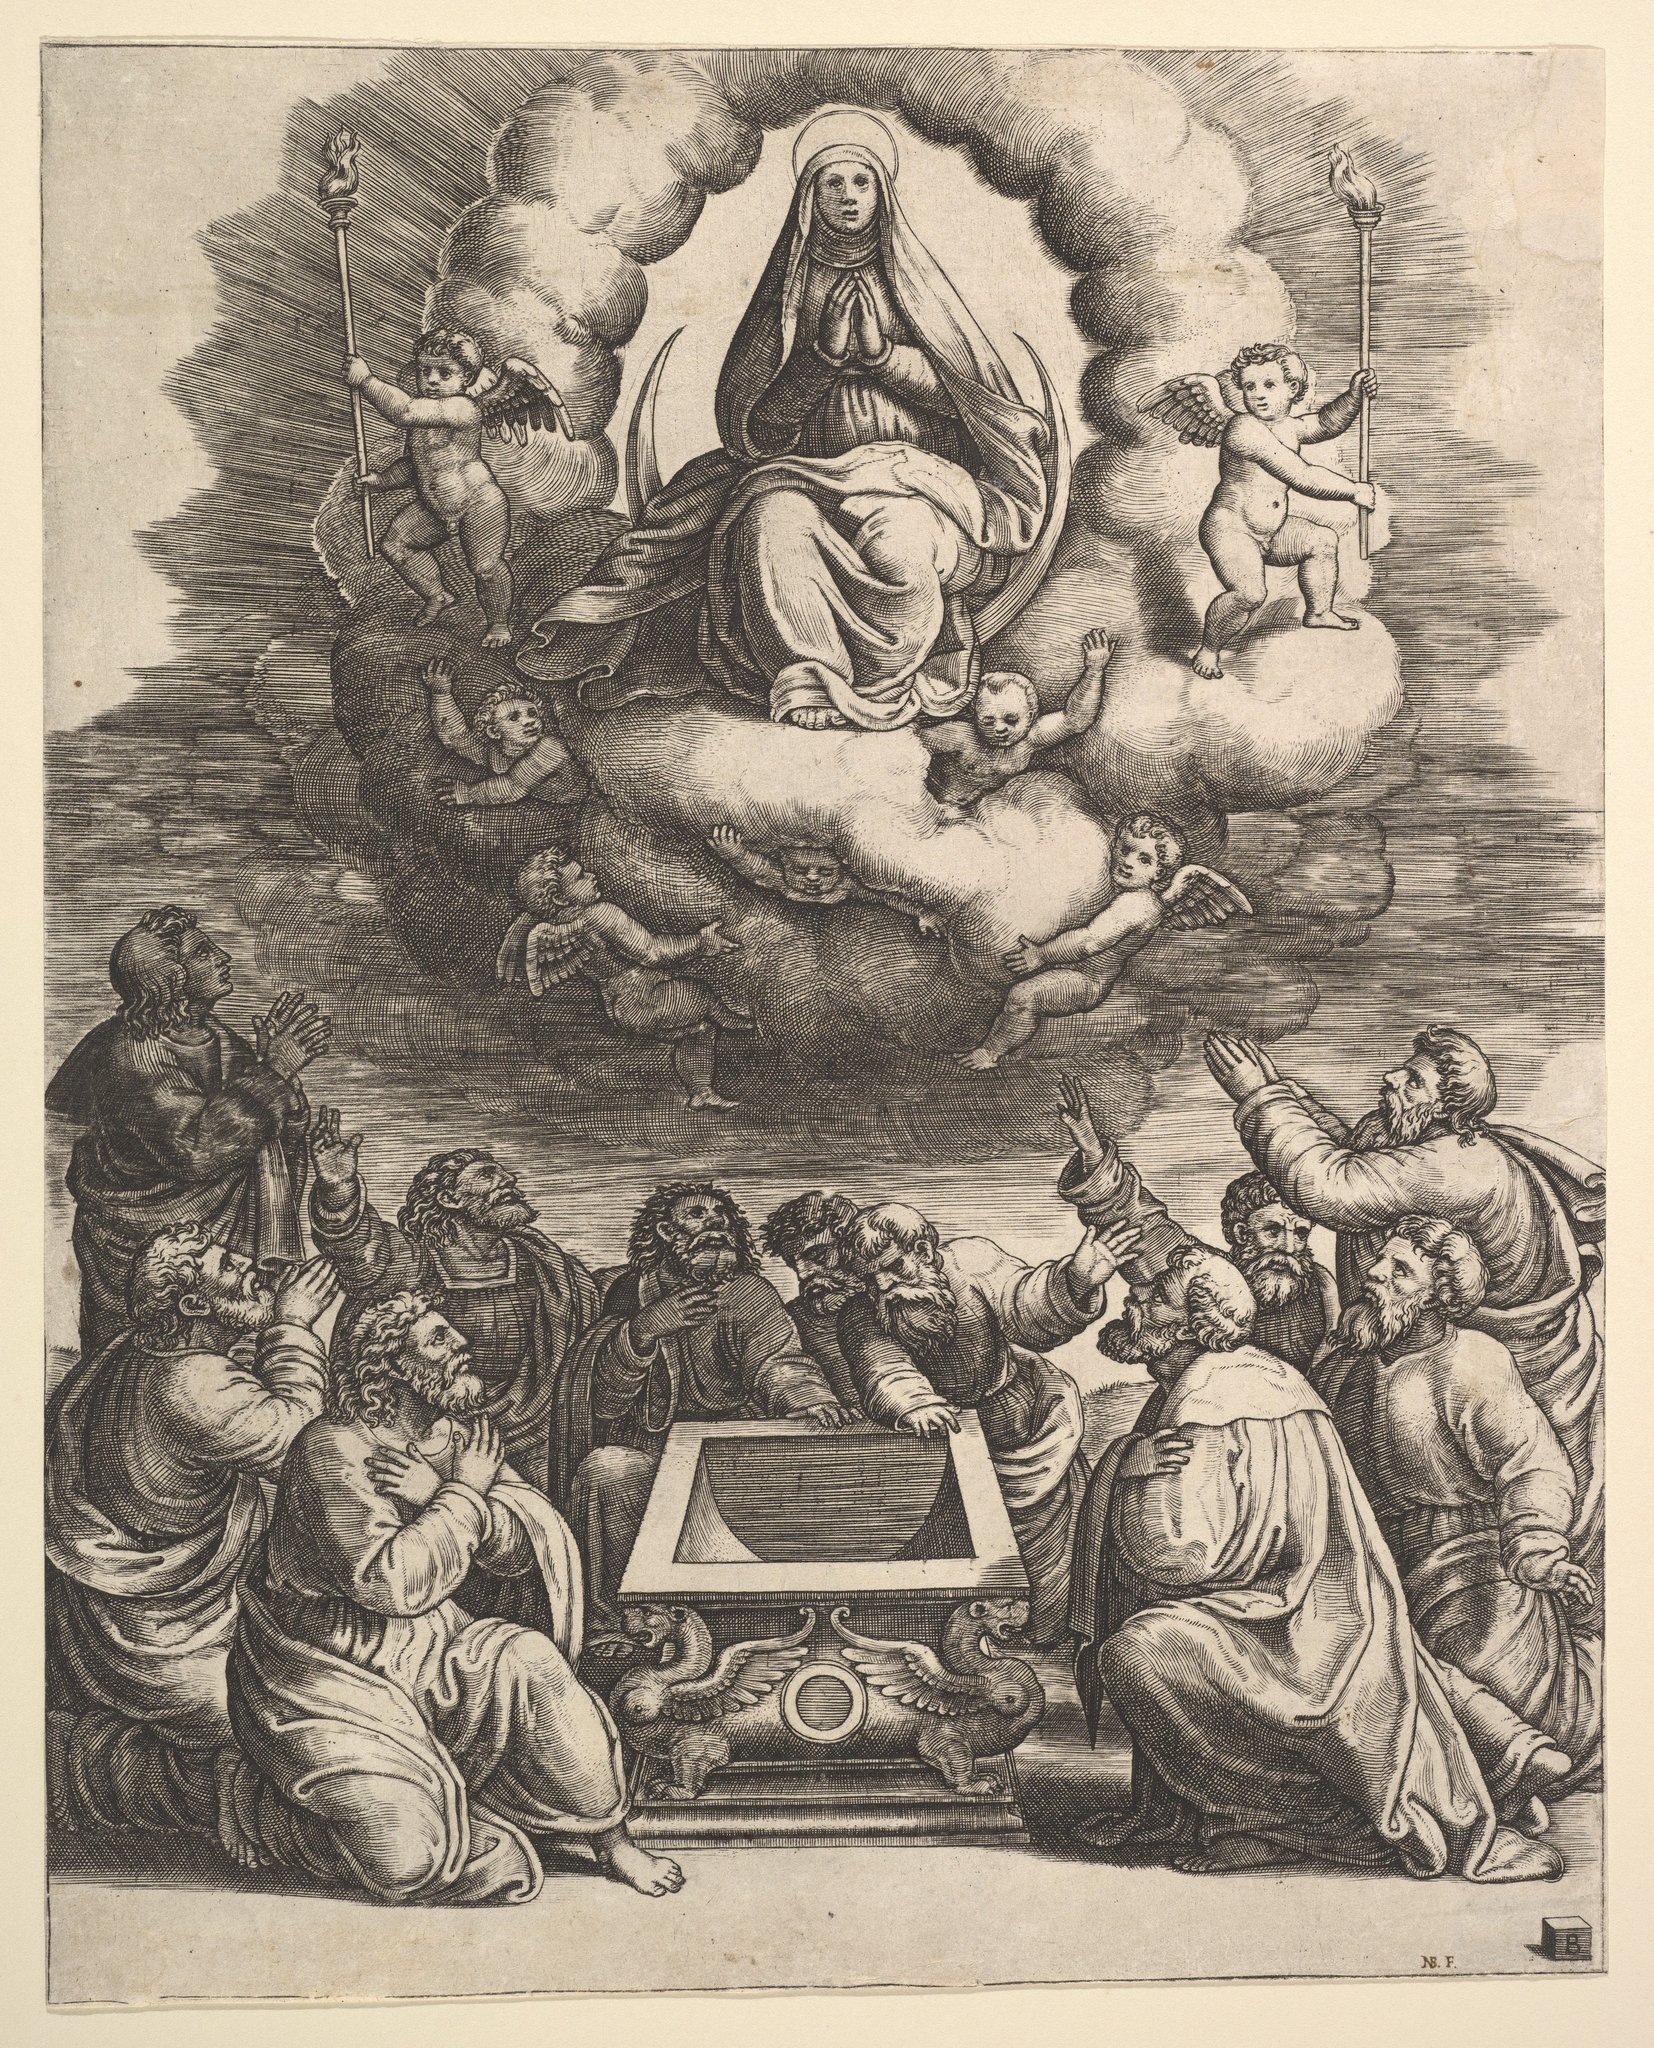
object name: print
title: The Assumption of the Virgin, below the apostles surround the tomb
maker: master of the die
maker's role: artist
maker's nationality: italian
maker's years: 1525-1560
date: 1530-1560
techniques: engraving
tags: tombs,angels,apostles,virgin mary,assumption of the virgin